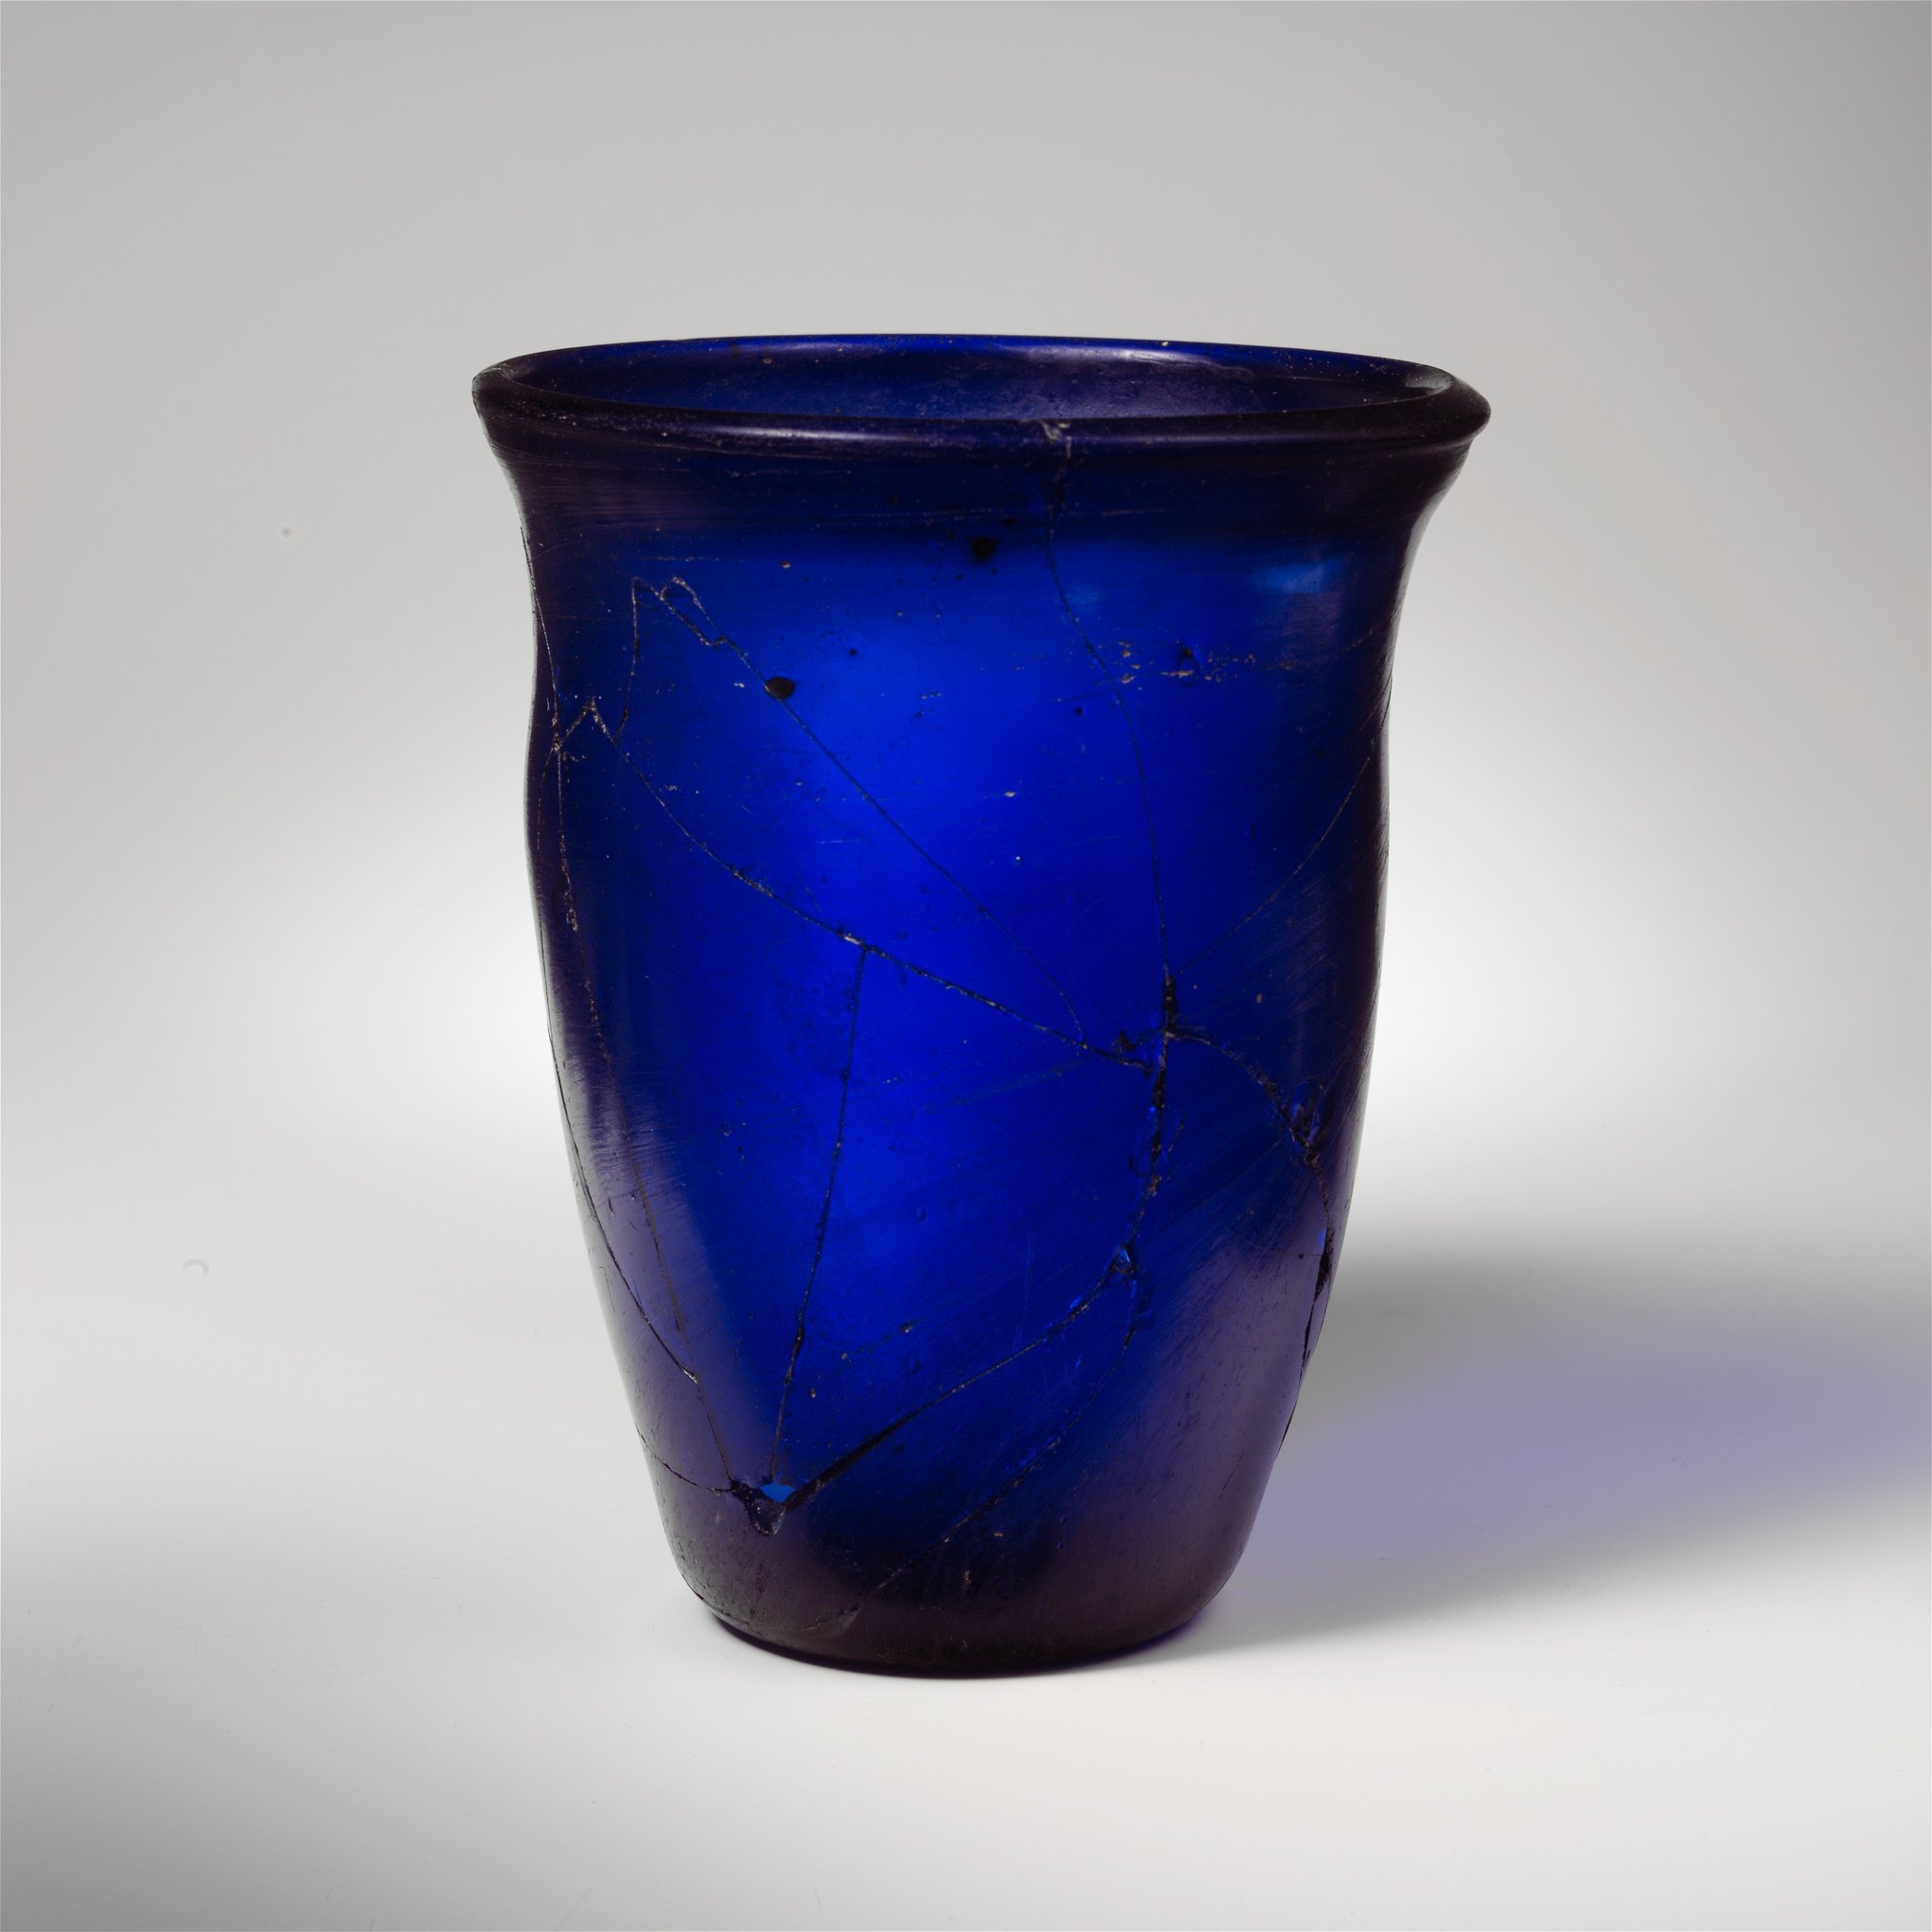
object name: beaker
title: Glass beaker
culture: roman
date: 301-400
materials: glass